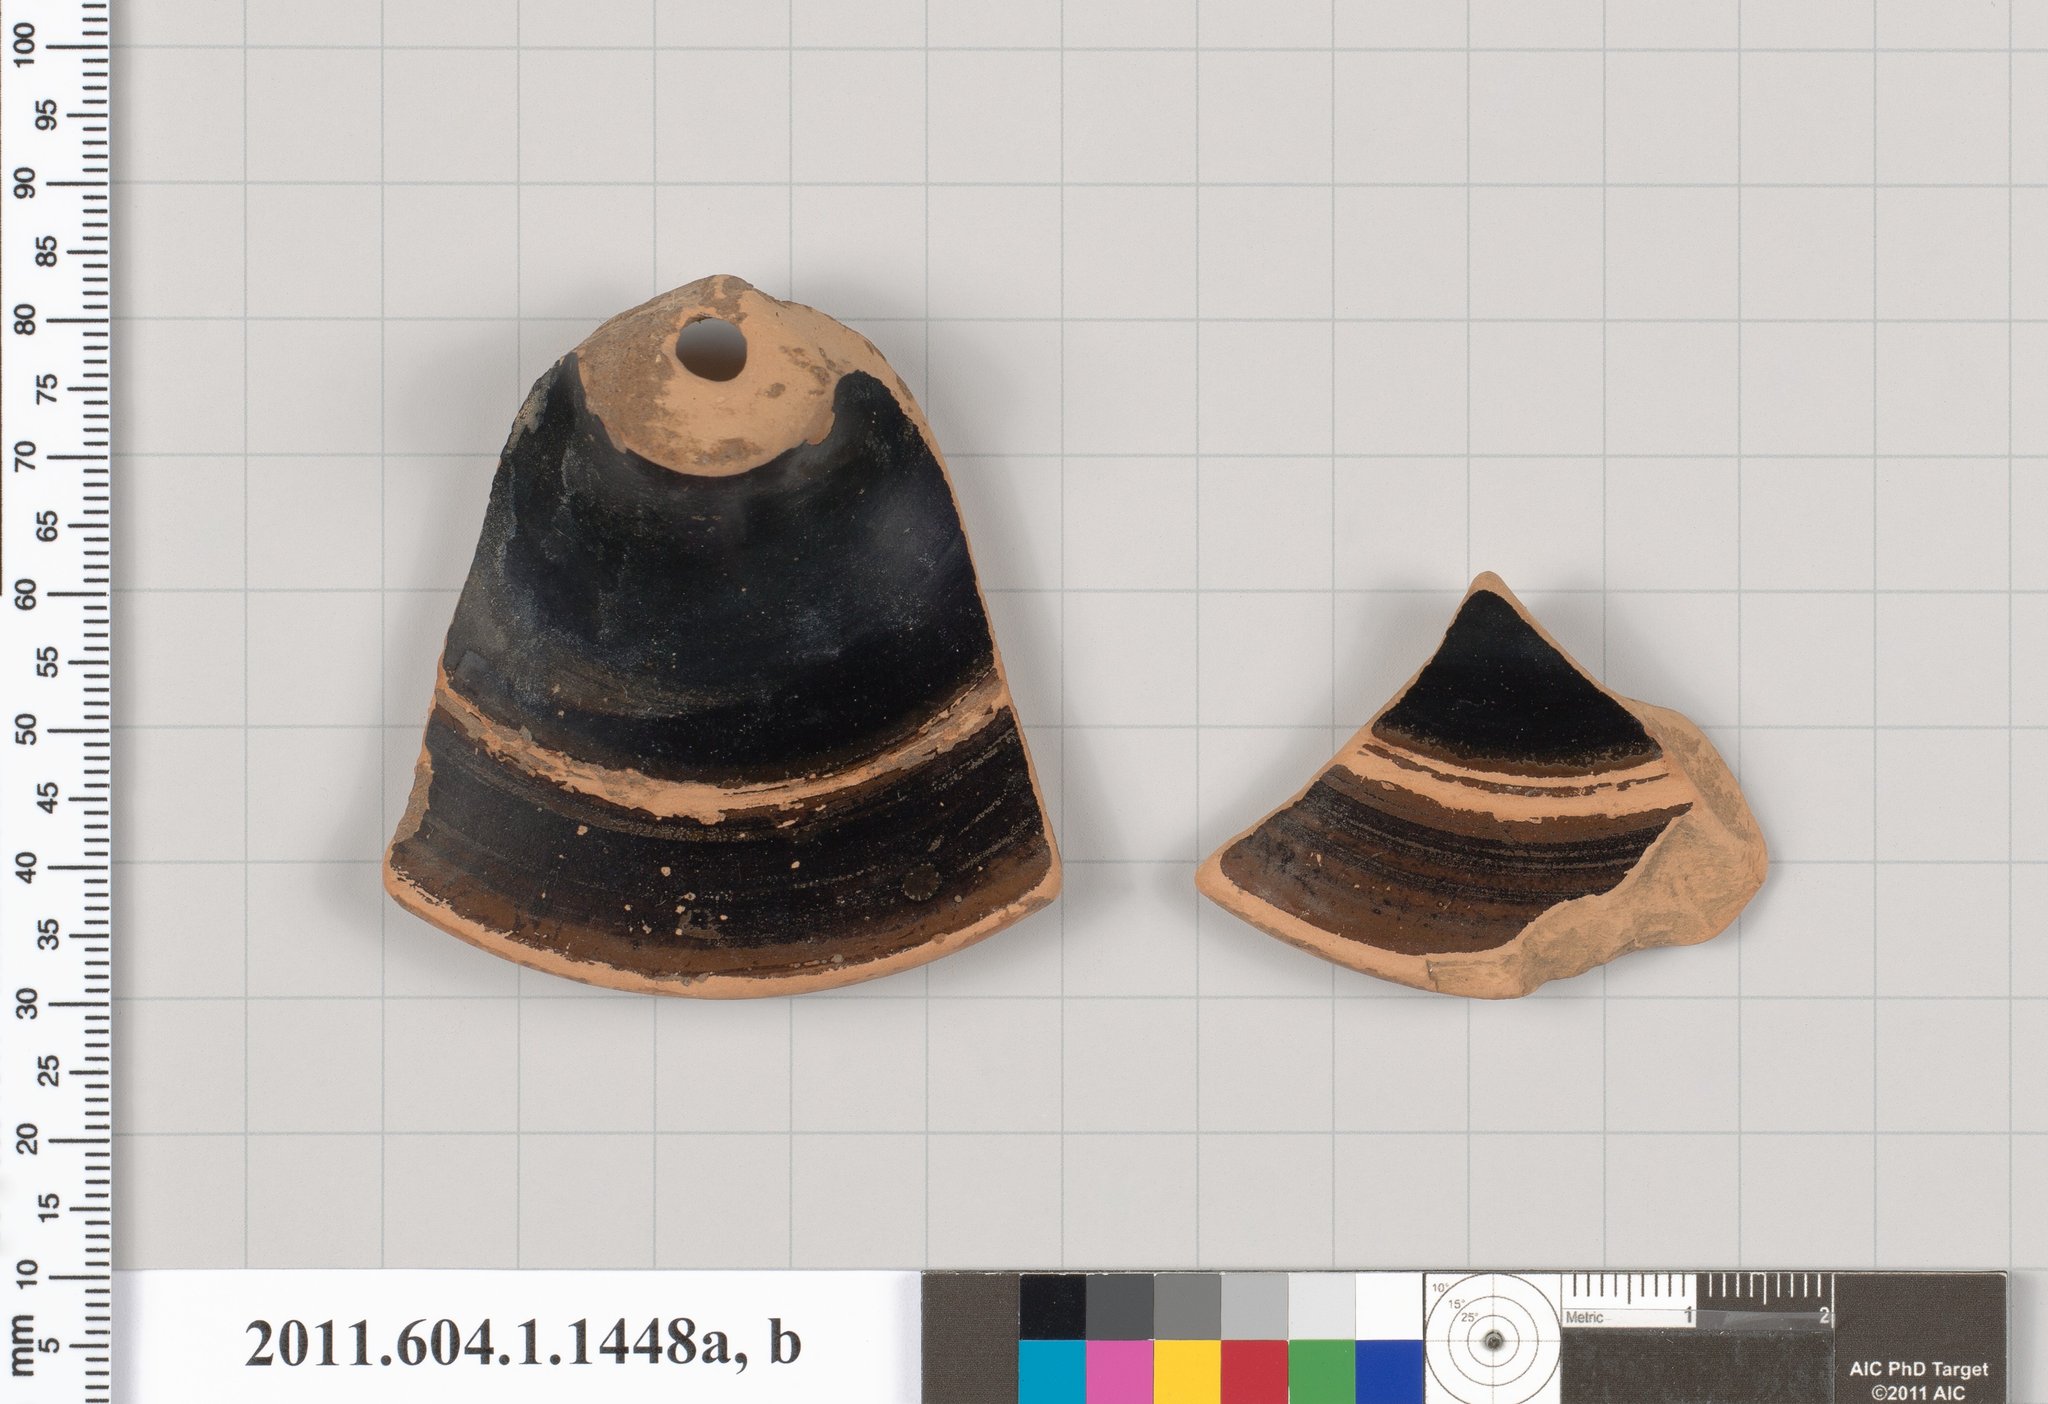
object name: kylix fragment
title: Terracotta fragments of a kylix (drinking cup)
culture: greek, attic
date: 500-401 BCE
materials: terracotta